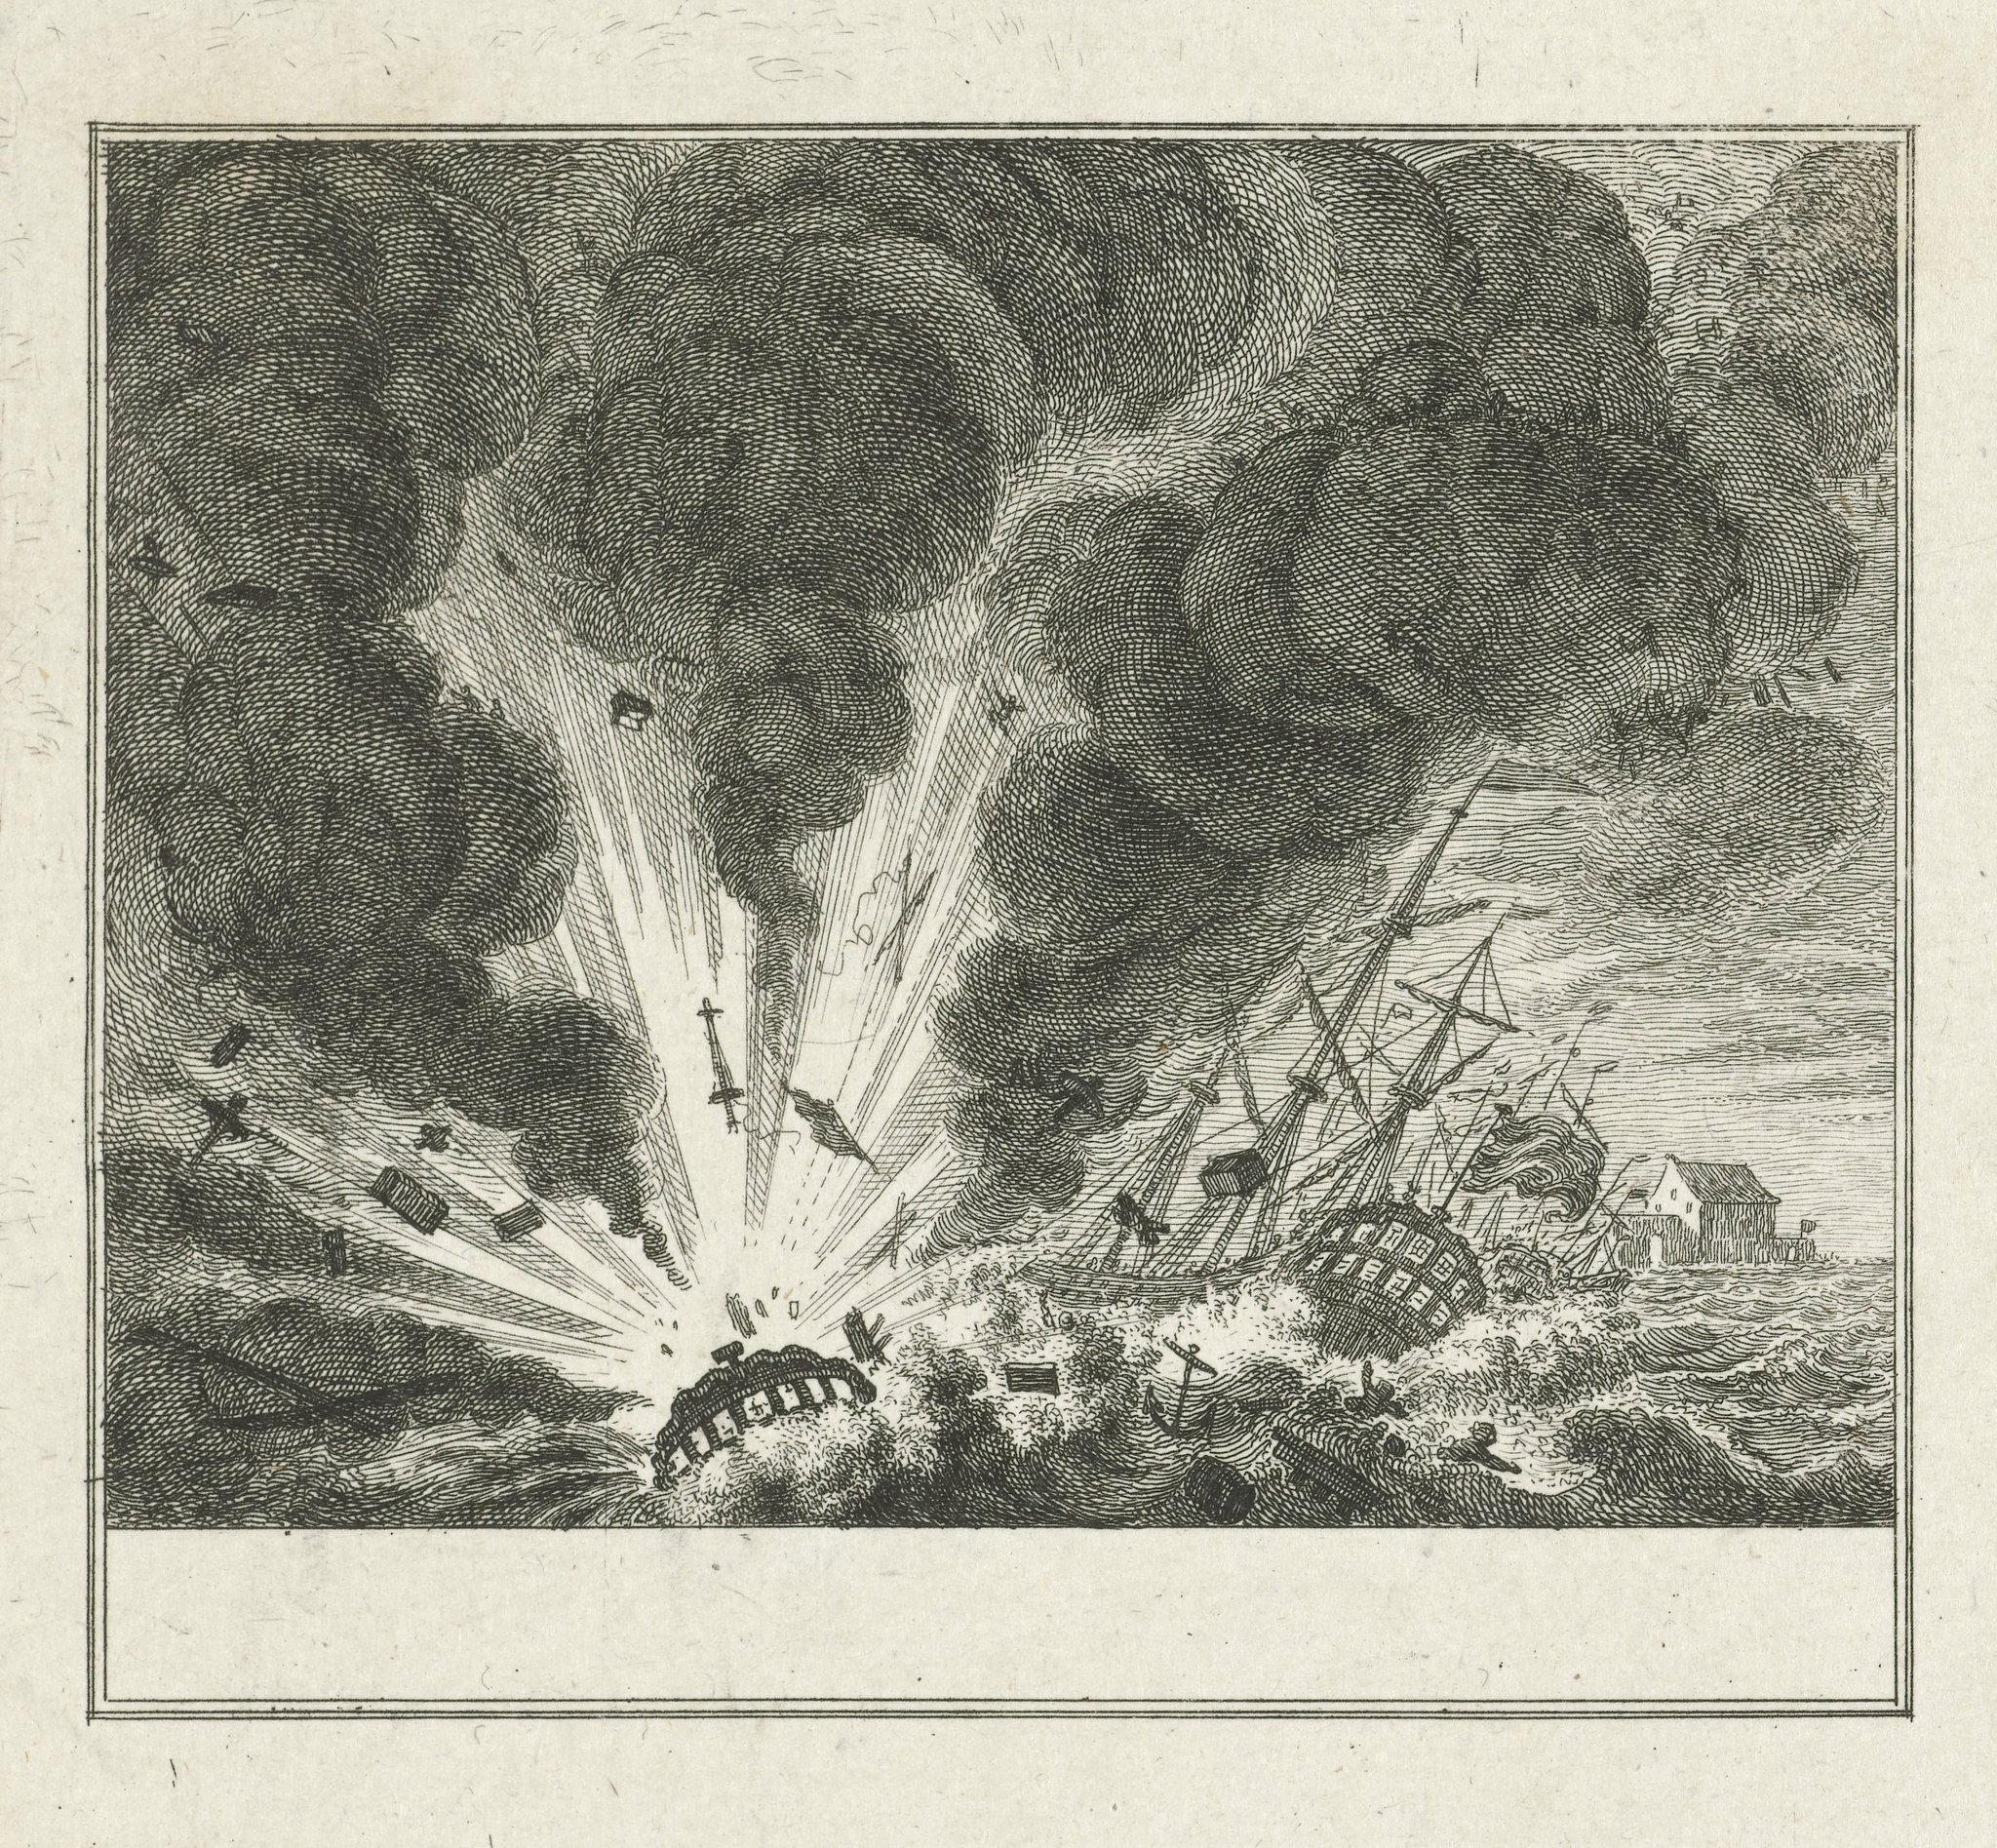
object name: print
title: Het ontploffen van het Nederlandse oorlogsschip Alphen voor Curacao, 1778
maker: simon fokke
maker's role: draughtsman, print maker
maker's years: 1712-1784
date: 1778-1780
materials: paper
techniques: etching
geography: amsterdam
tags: gunpowder disaster (+ sailing-ships), drowning, shipwrecked person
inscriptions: collector's mark: Lugt 2228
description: Illustratie voor een onbekend werk, later hergebruikt in: J.W. te Water, De vaderlandsche Historie van den heere J. Wagenaar, verkort, en met leerzaame aanmerkingen, ten dienste der Nederlandsche jeugd, 1784-1800, 4 delen.